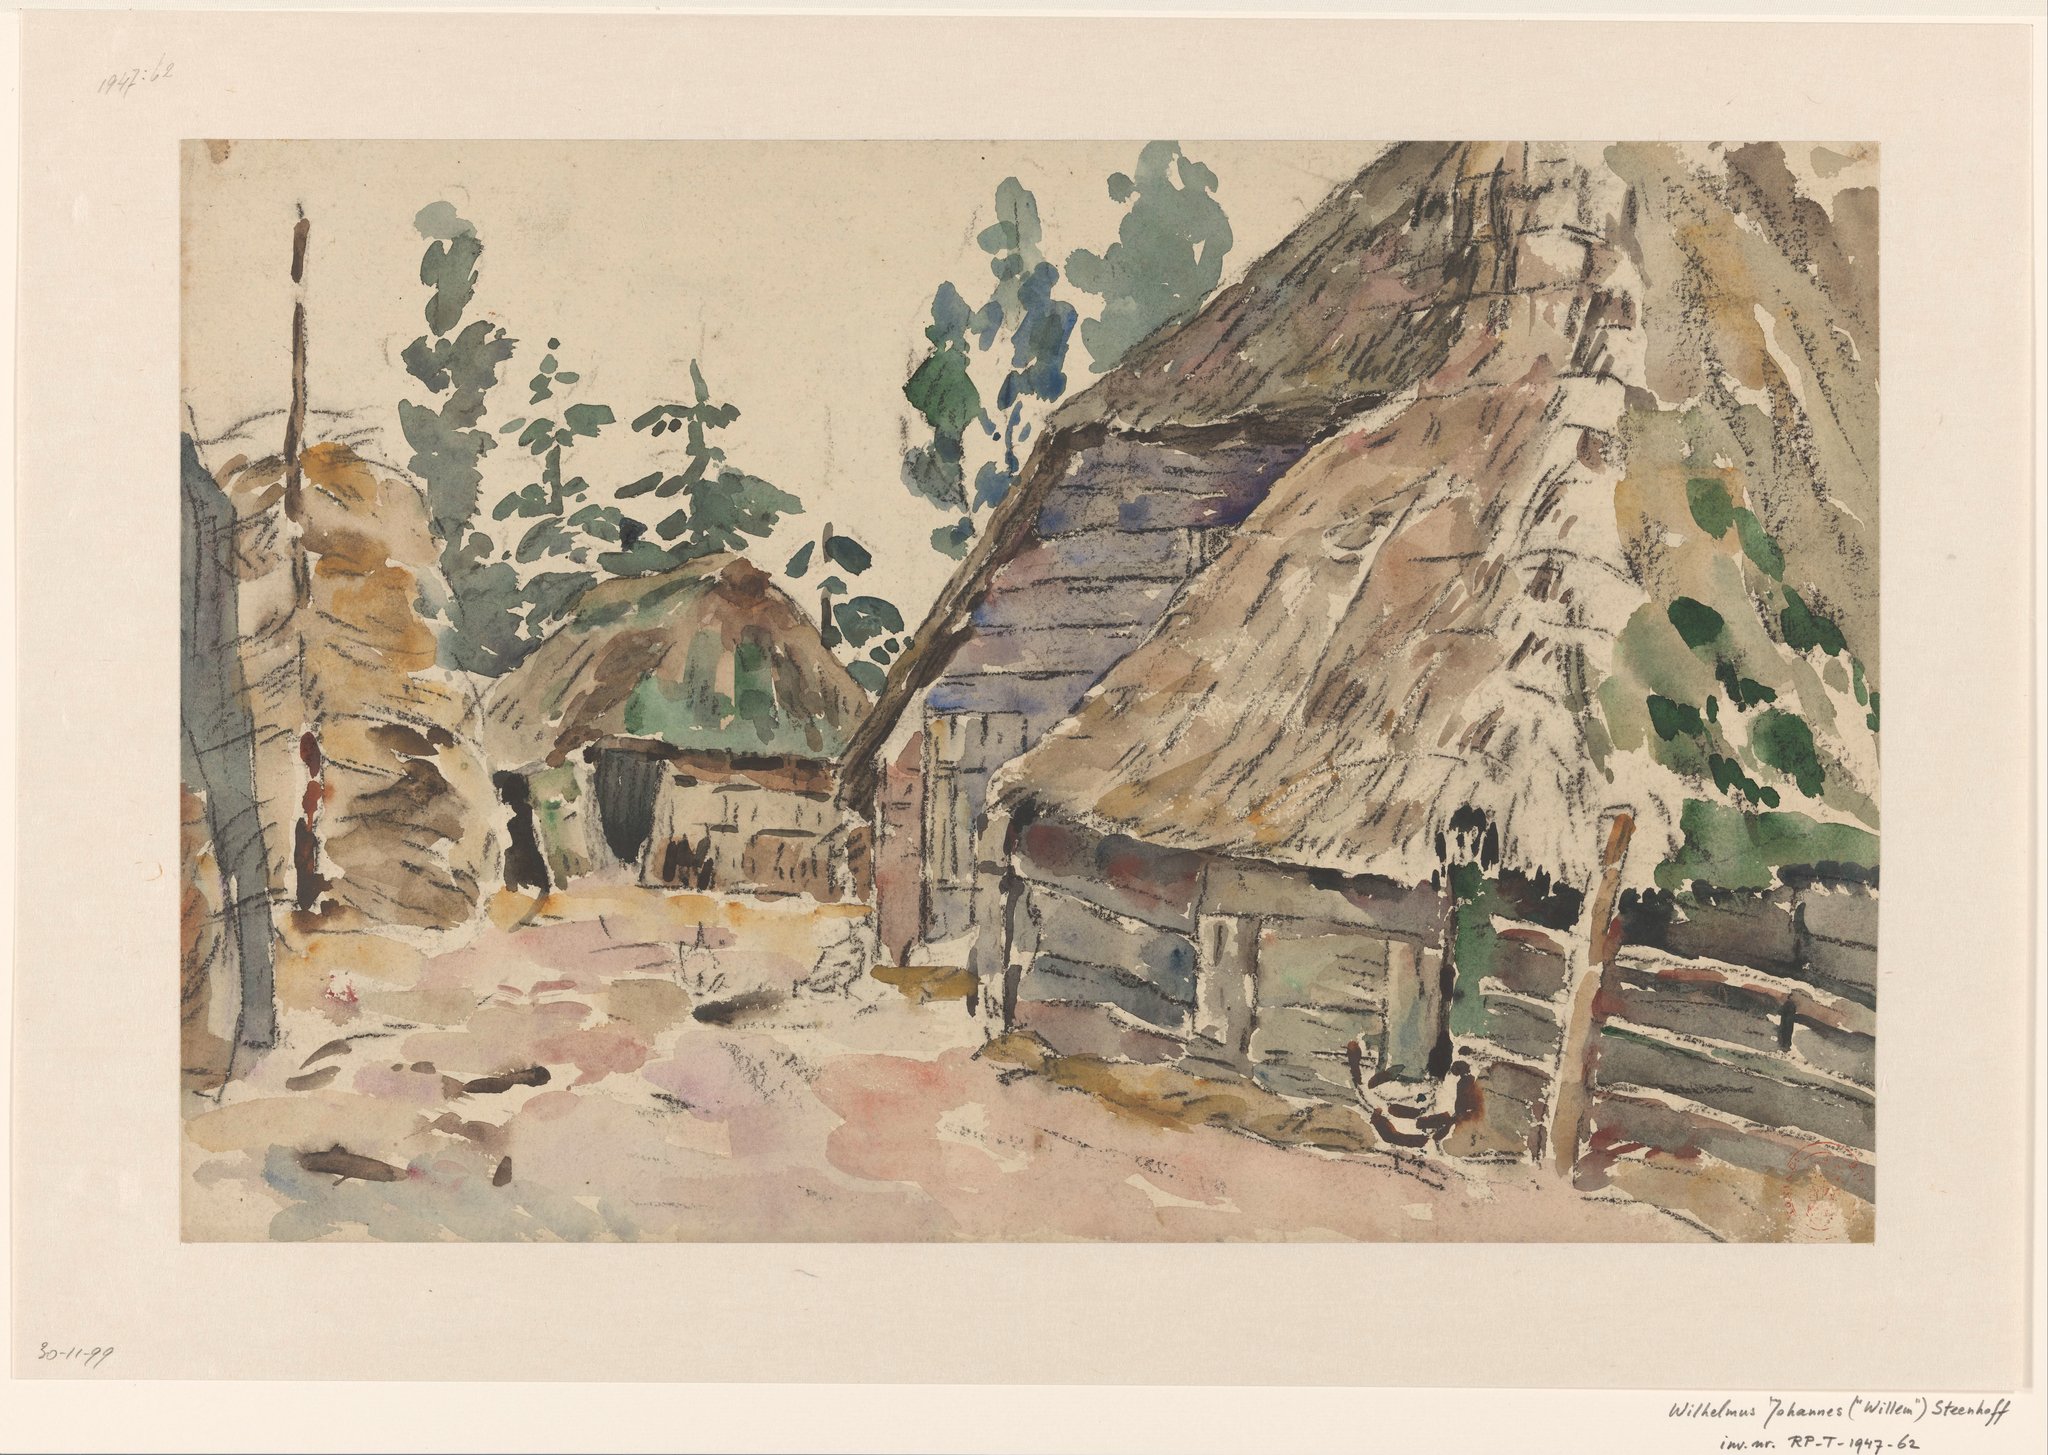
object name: drawing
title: Boerenerf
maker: wilhelmus johannes steenhoff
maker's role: draughtsman, print maker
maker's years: 1863-1932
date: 1873-1932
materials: chalk, paper, watercolor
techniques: brush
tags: farm (building)